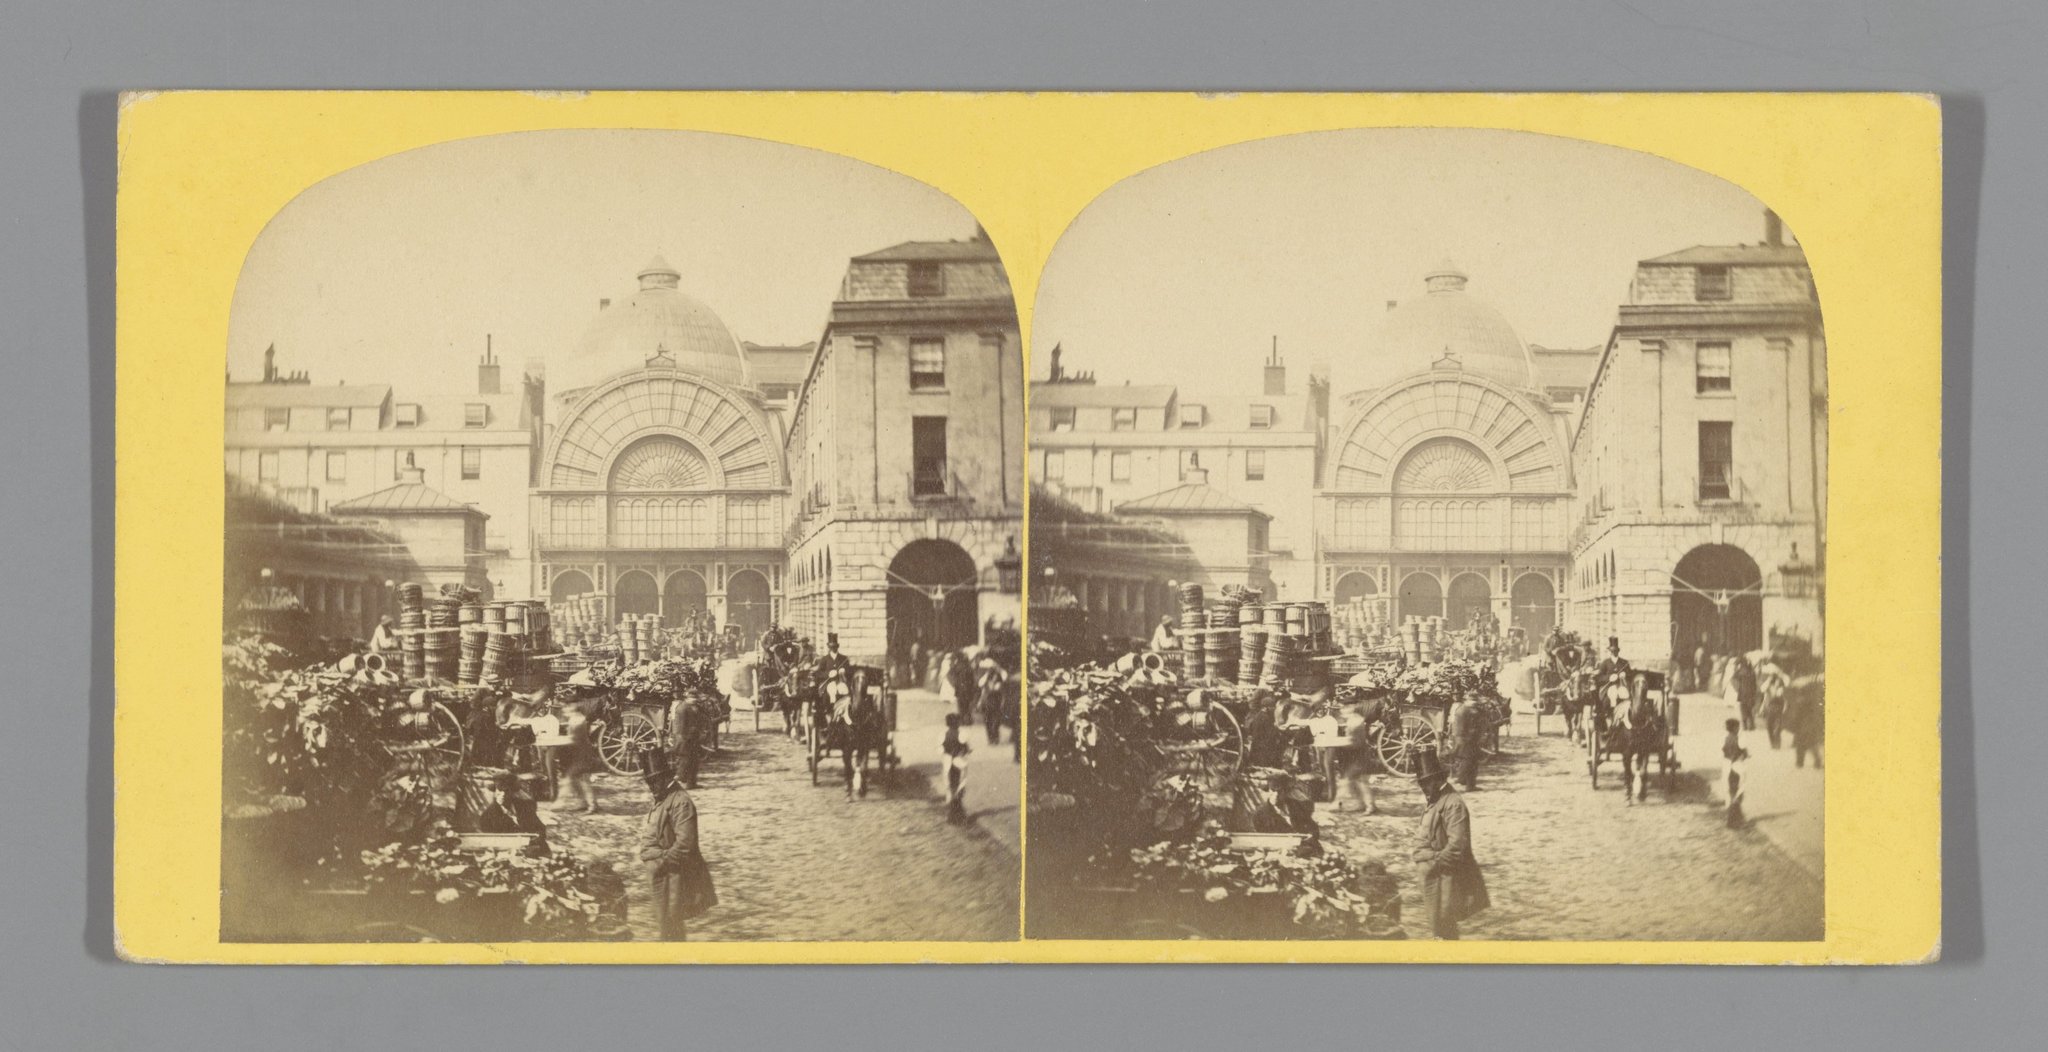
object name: stereograph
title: Gezicht op de Floral Hall in Covent Garden met handelaren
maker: Anonymous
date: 1850-1880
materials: cardboard, photographic support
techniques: albumen print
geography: london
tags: four-wheeled, animal-drawn vehicle, e.g.: cab, carriage, coach, trade, commerce and finance, market-hall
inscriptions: inscription, number: ‘No. 184.’